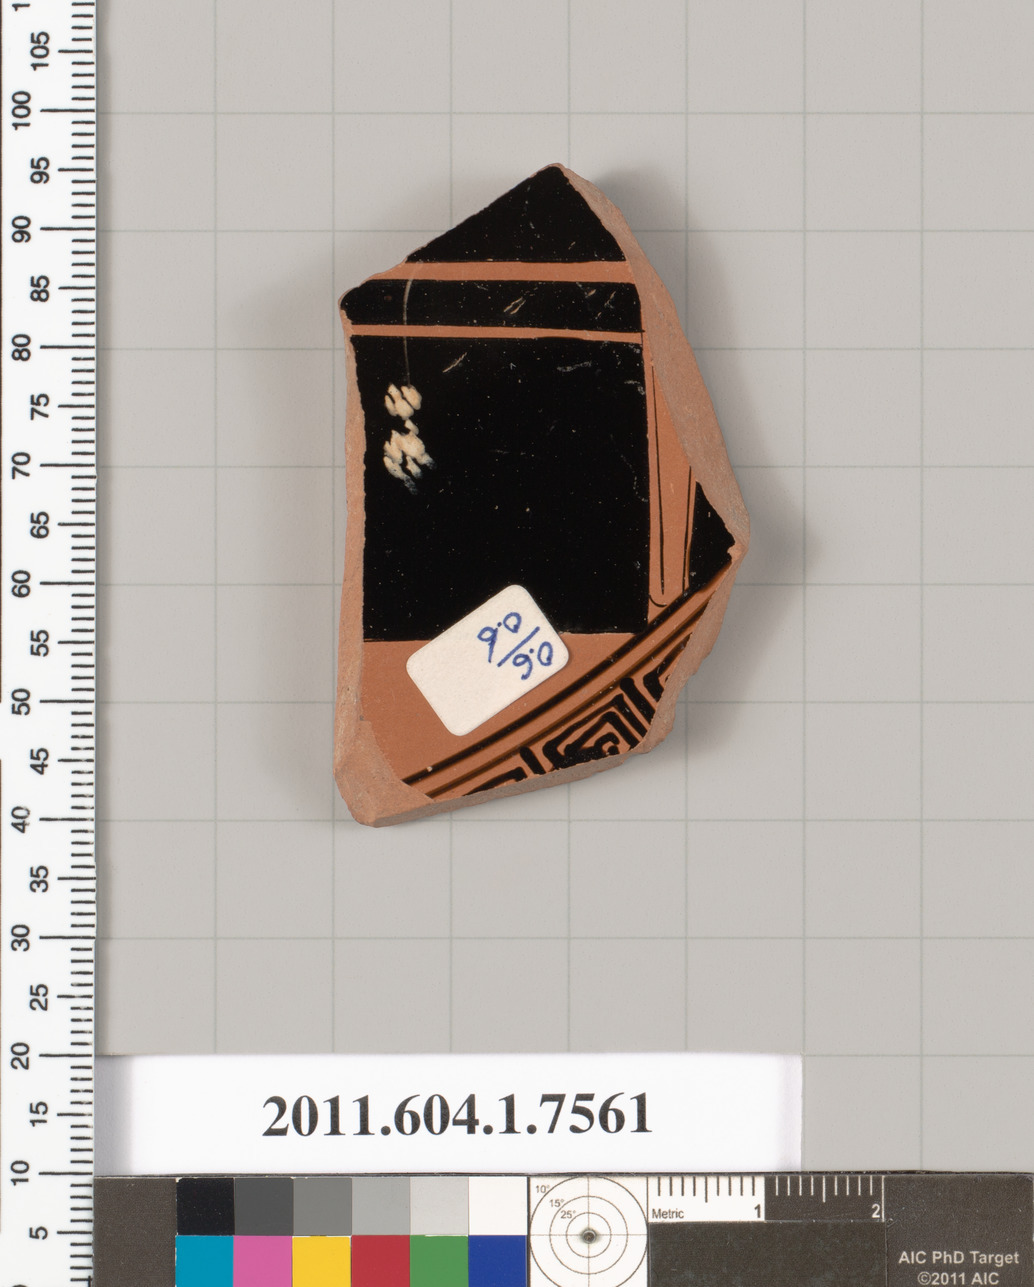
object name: kylix fragment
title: Terracotta fragment of a kylix (drinking cup)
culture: greek, attic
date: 460-450 BCE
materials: terracotta